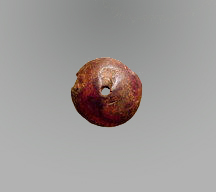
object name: disk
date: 600-401 BCE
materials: amber